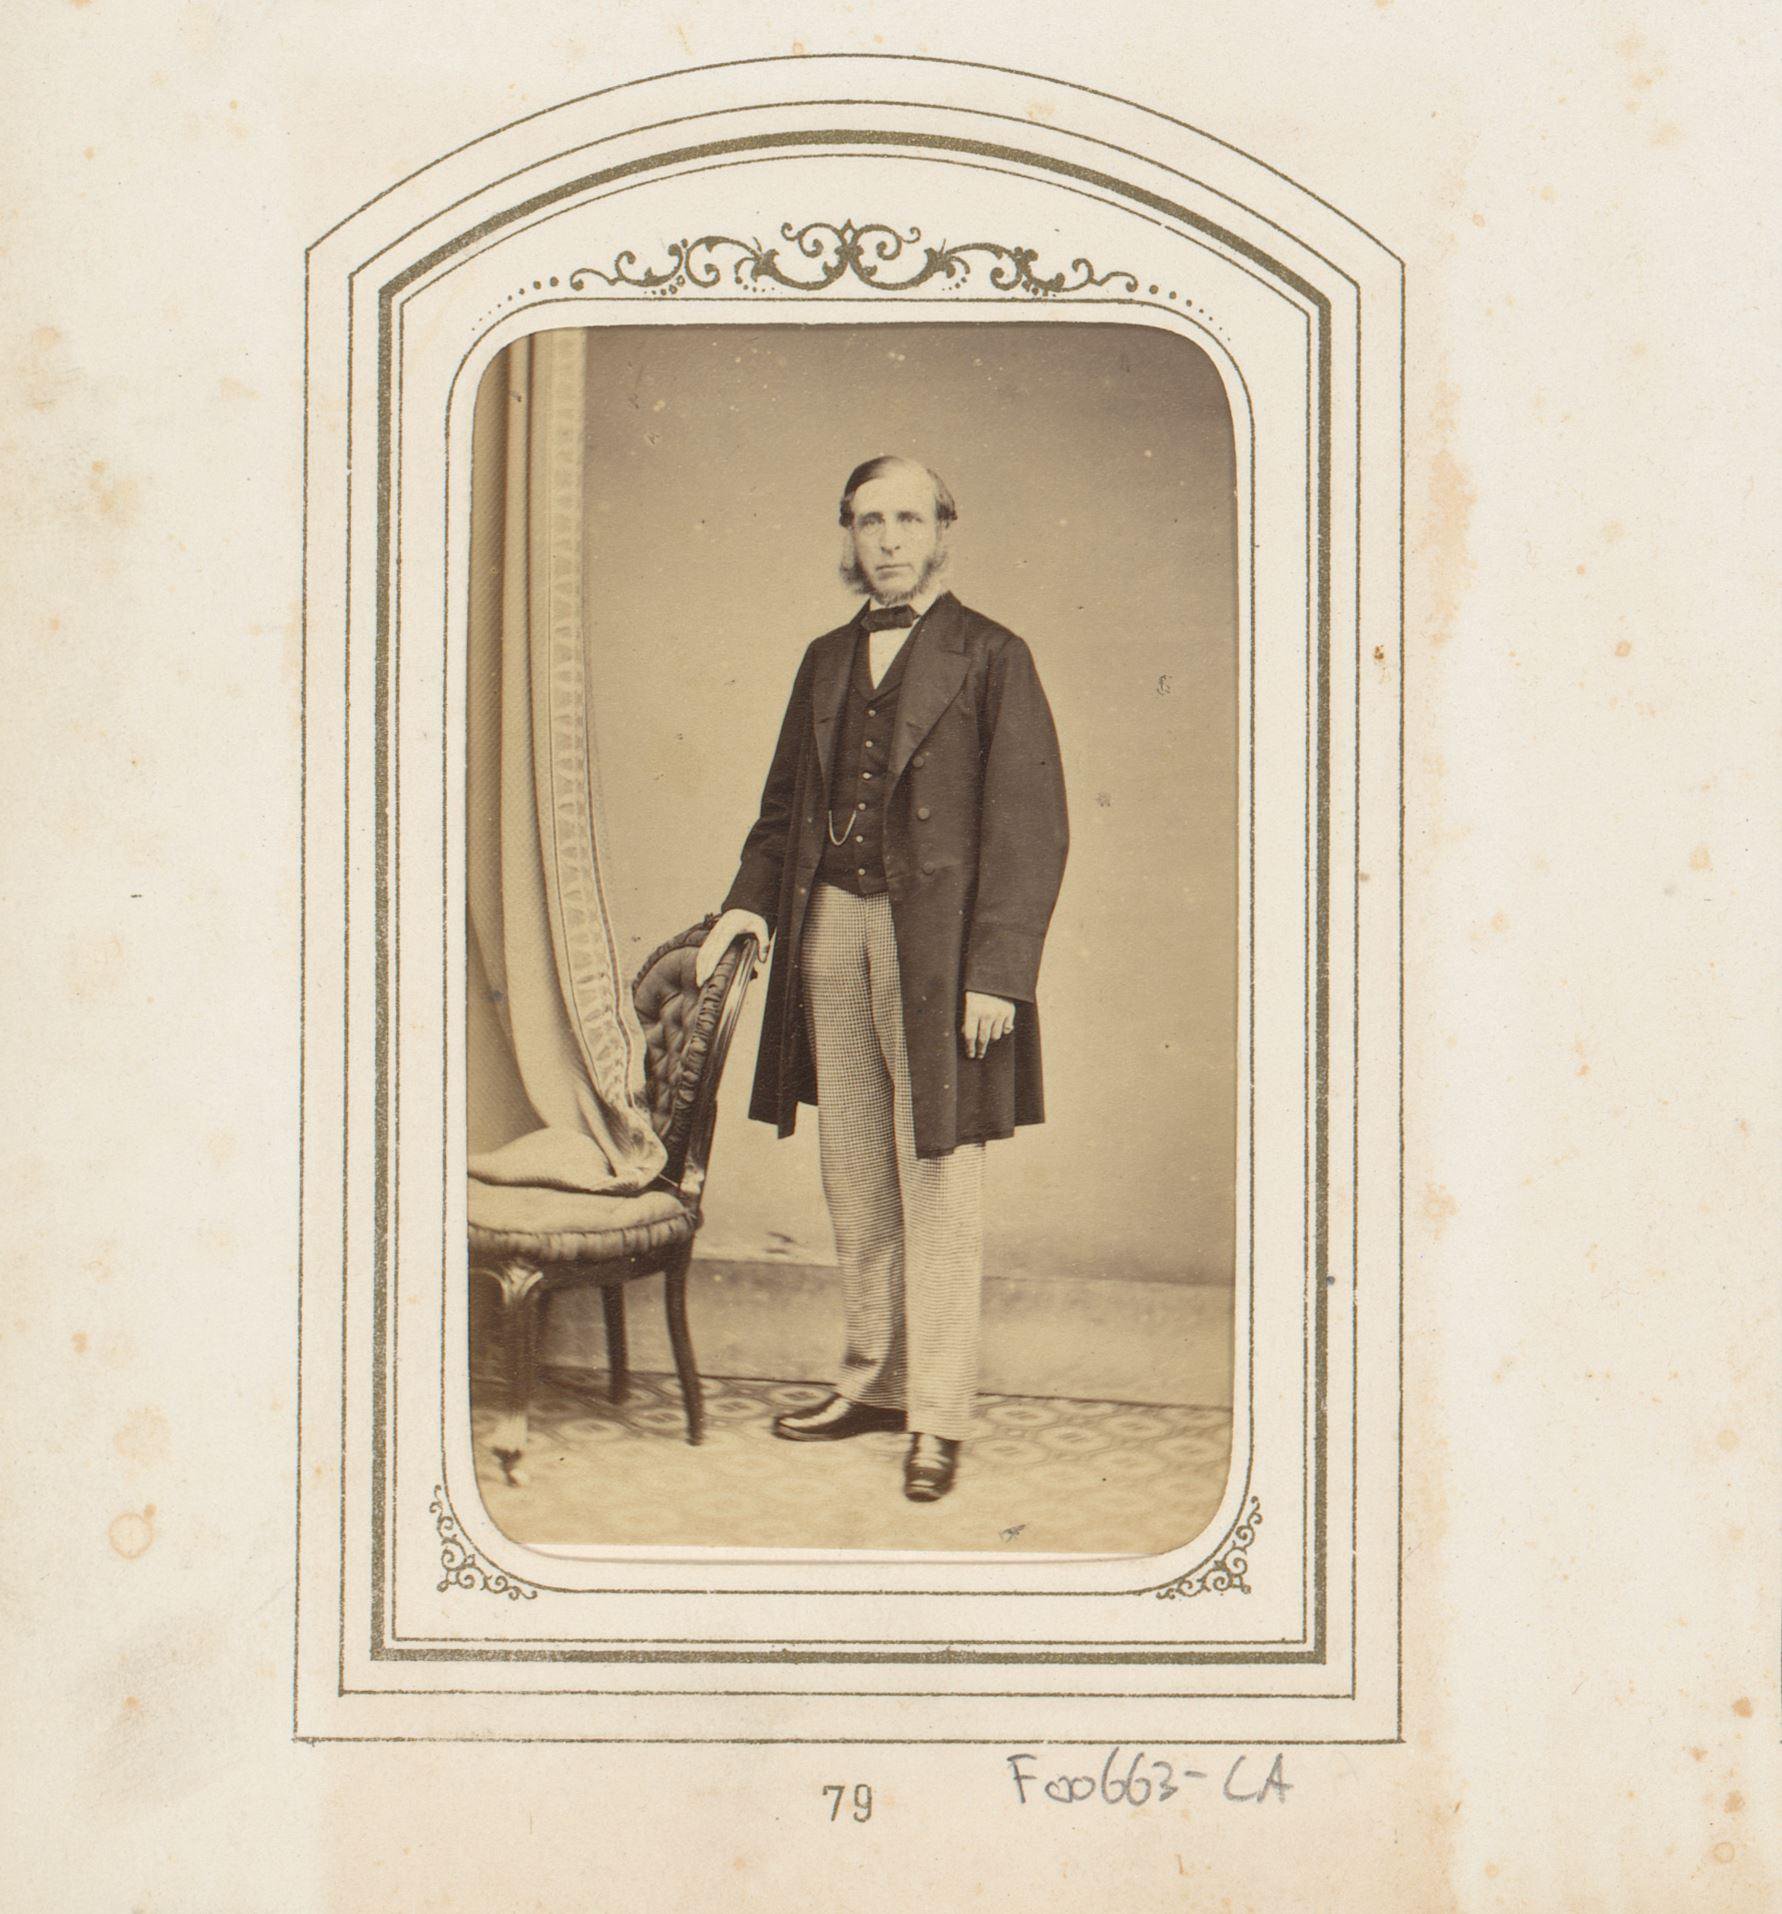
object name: carte de visite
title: Portret van een staande oude vrouw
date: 1854-1865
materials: cardboard, photographic support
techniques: albumen print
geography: london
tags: historical persons - bb - woman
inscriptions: number: ‘80’, inscription: ‘Maull & Polyblank/ Photographers/ 55, Gracechurch street/ 187a, Piccadilly and Tavistock House Fulham Road/ London’